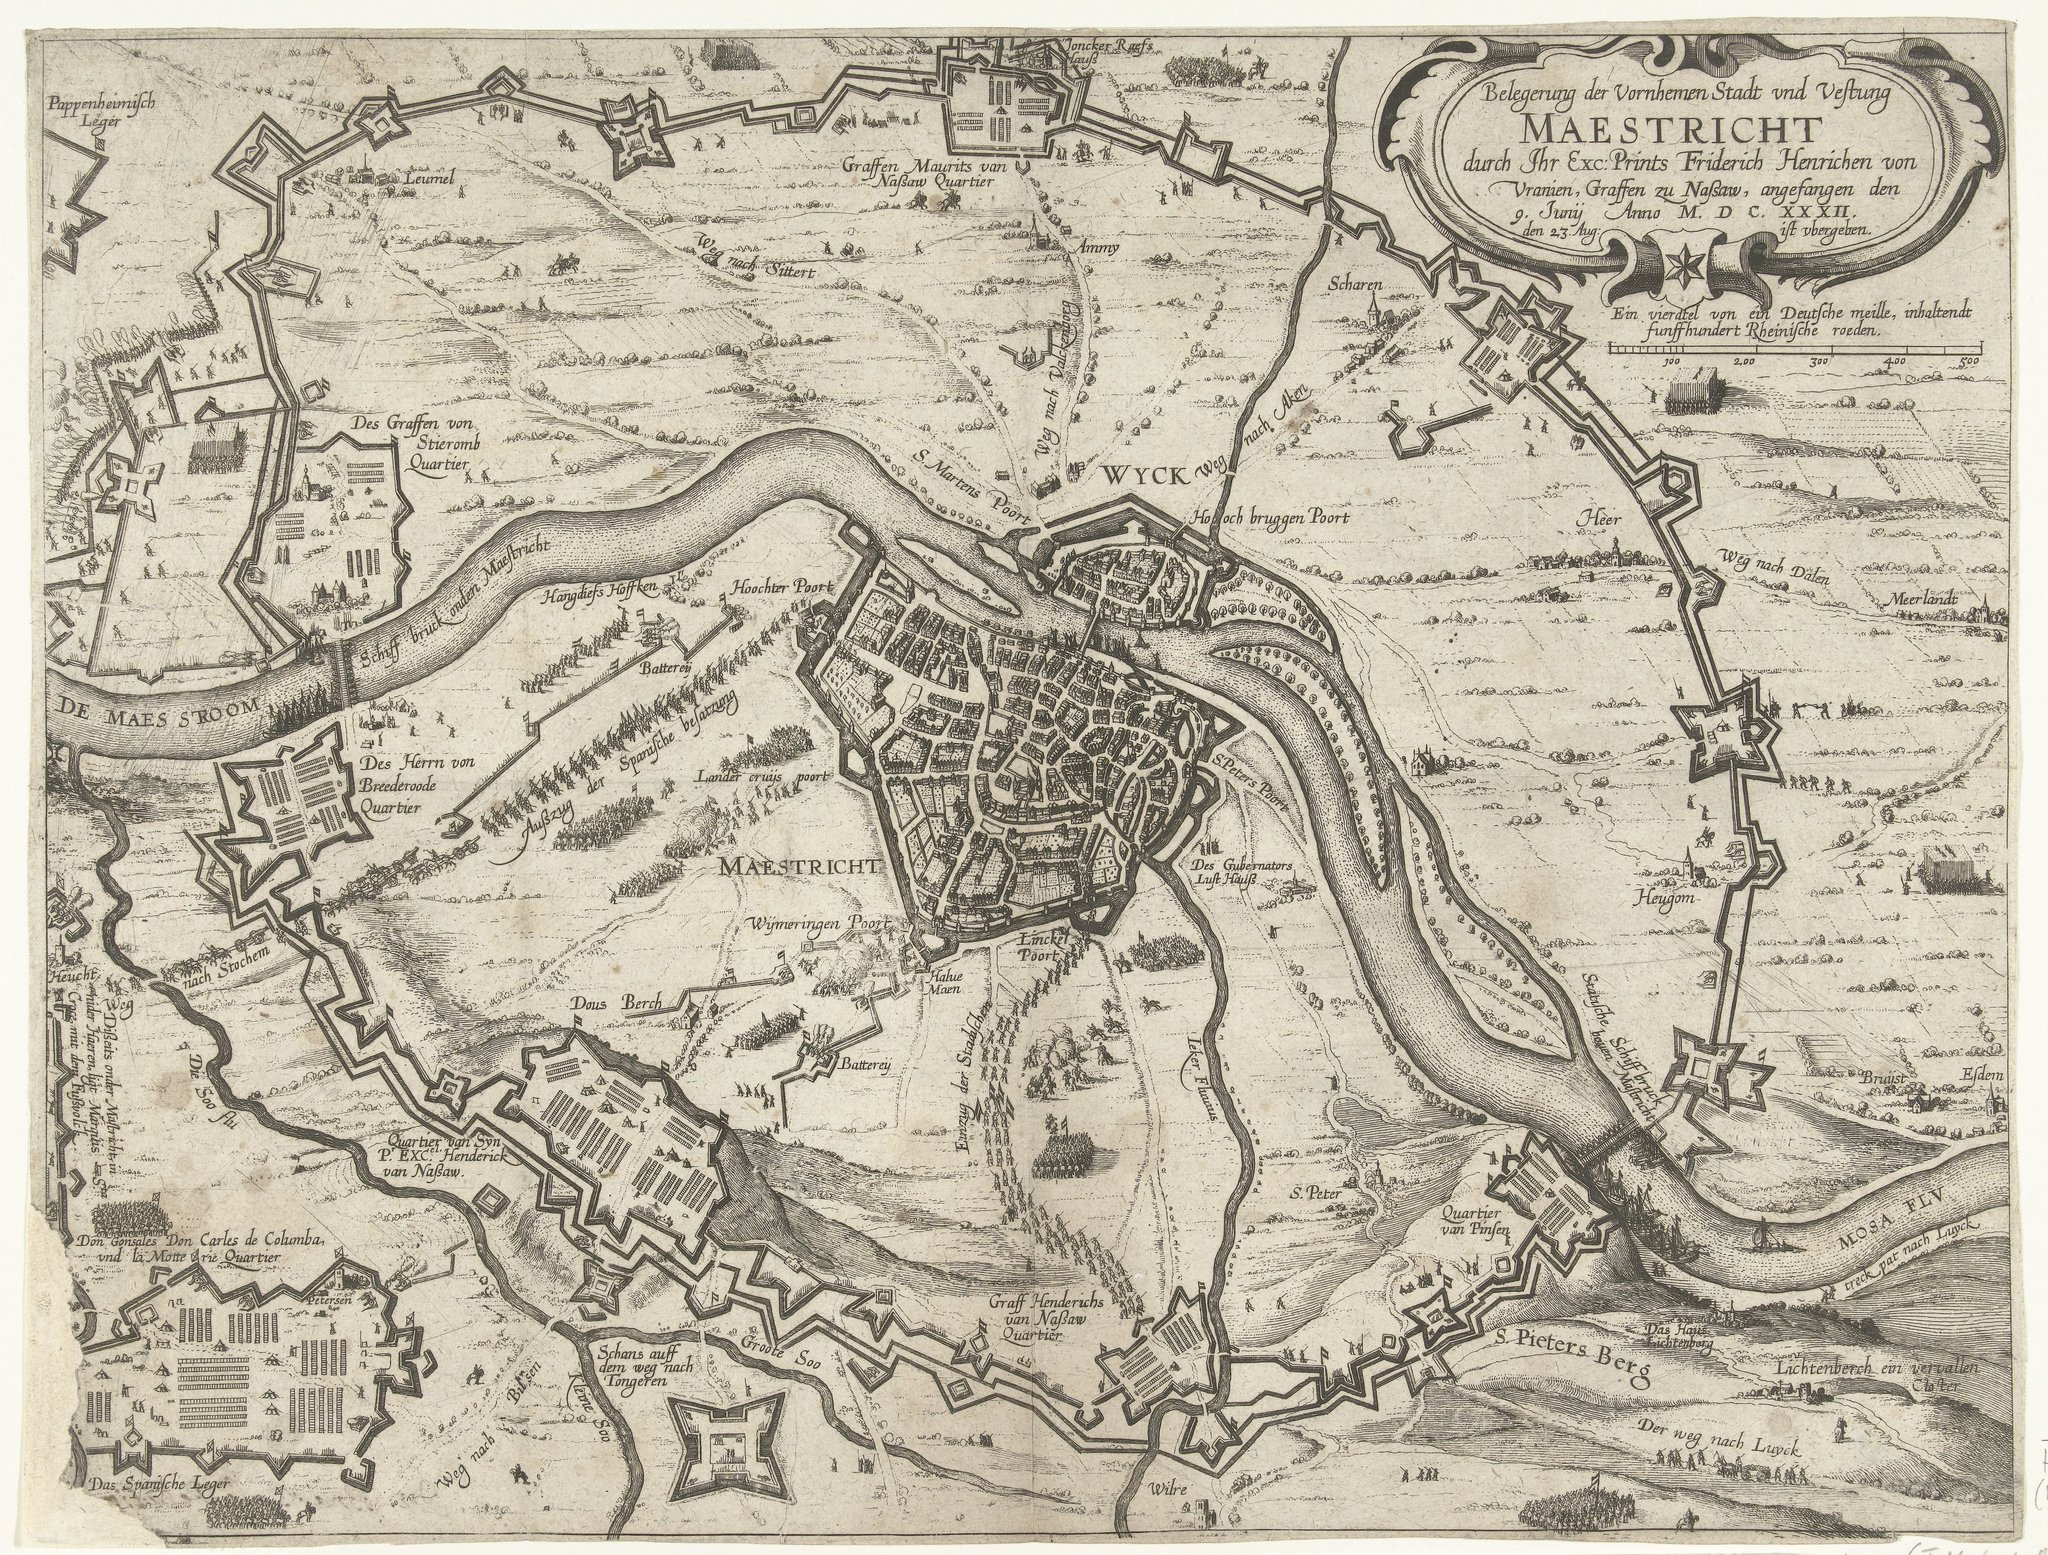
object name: map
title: Blegerung der Vornhemen Stadt und Vestung Maestricht durch Ihr Exc. Prints Friderich Henrichen von Uranien, Graffen zu Nassaw, angefangen den 9. Junij Anno MDCXXXII, den 23 Aug. ist ubergeben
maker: wenceslaus hollar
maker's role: draughtsman, print maker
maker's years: 1607-1677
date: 1632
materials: paper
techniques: etching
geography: germany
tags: delft, the hague, frederick henry (prince of orange), maps of separate countries or regions, siege, position war, maastricht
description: Kaart van het beleg van Maastricht door het Staatse leger onder stadhouder Frederik Hendrik, 9 juni tot 21 augustus 1632. Omsingeling van de stad met de verschillende legerkampen van de belegeraars. Aan de linkerkant van de stad de uittocht van de Spaanse bezetters, onderaan de intocht van het Staatse leger. Met opschriften in de voorstelling in het Duits.